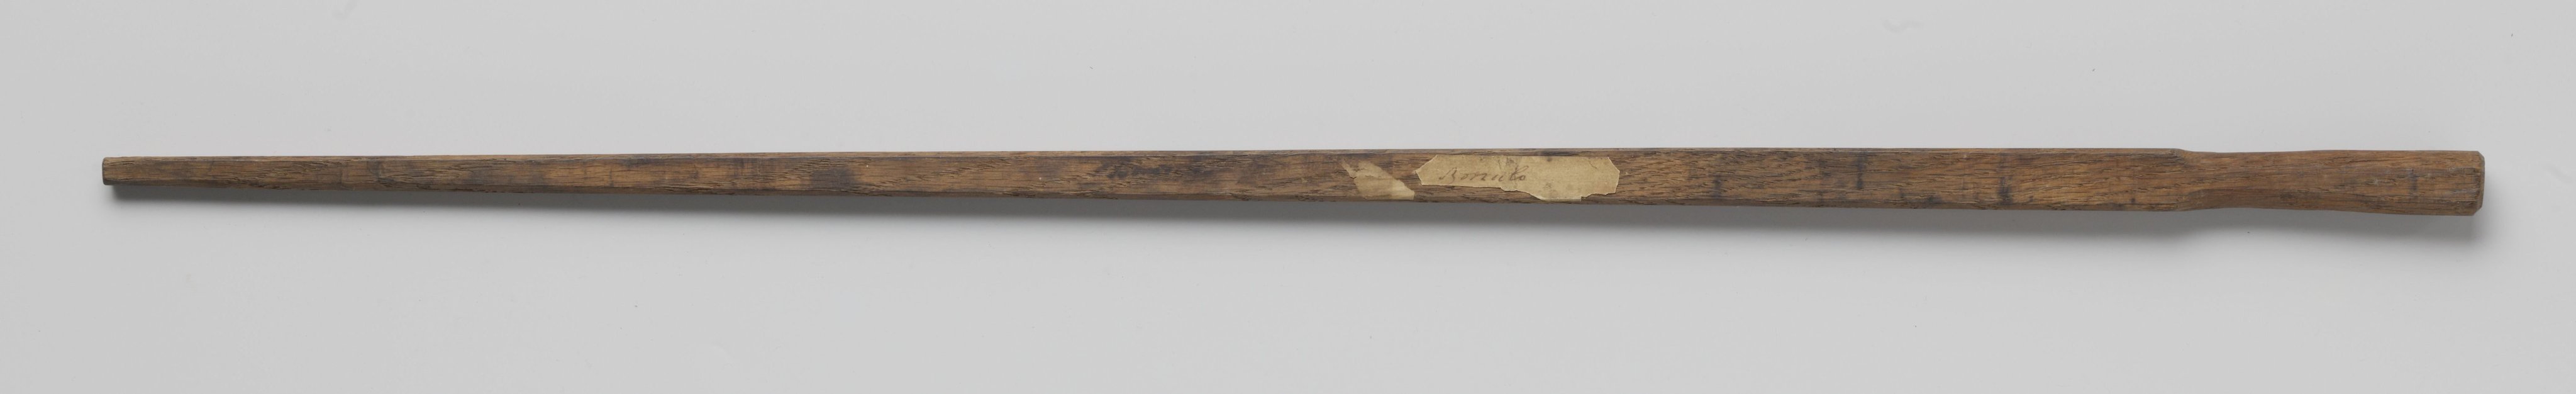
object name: ellemaat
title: Ellemaat uit Borculo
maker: Anonymous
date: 1800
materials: wood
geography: borculo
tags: borculo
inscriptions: inscription: ‘B.’, label: ‘Borculo’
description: Lengtemaat van 1 el met handvat uit Borculo. Opschrift met inkt (onleesbaar) en v.z.v. etiket.